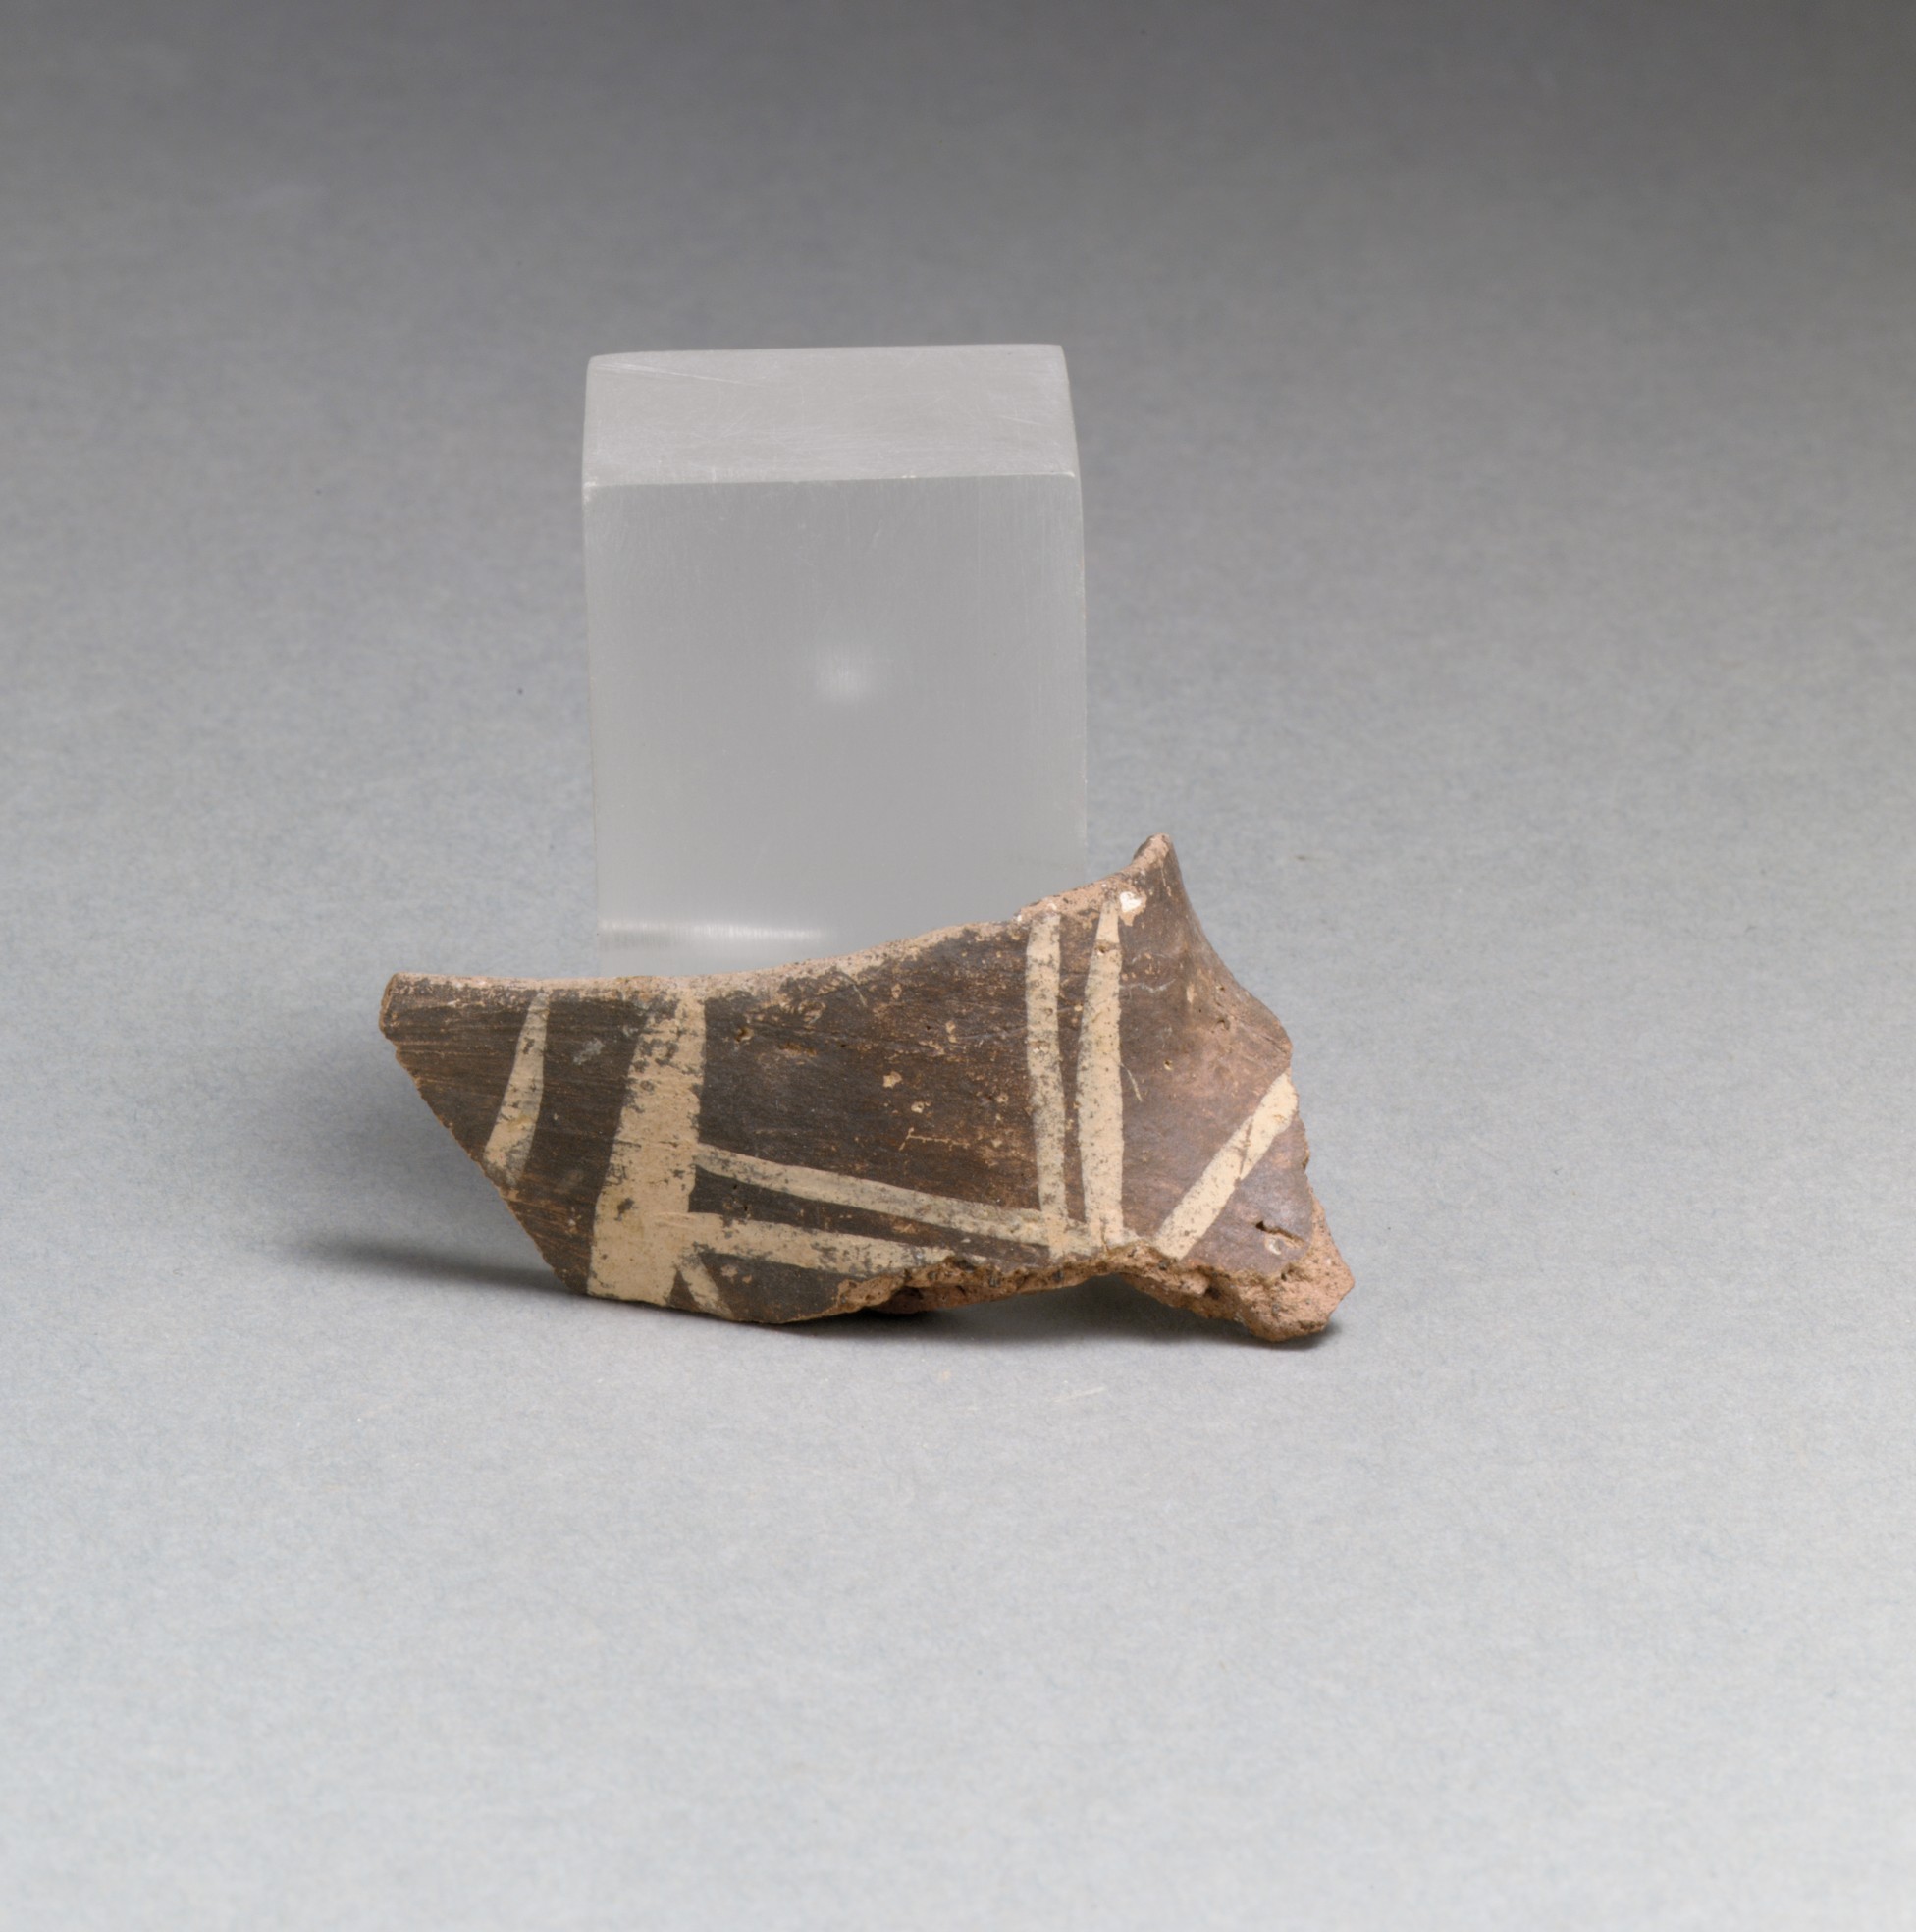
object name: vase fragment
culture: minoan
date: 2600-2000 BCE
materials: terracotta